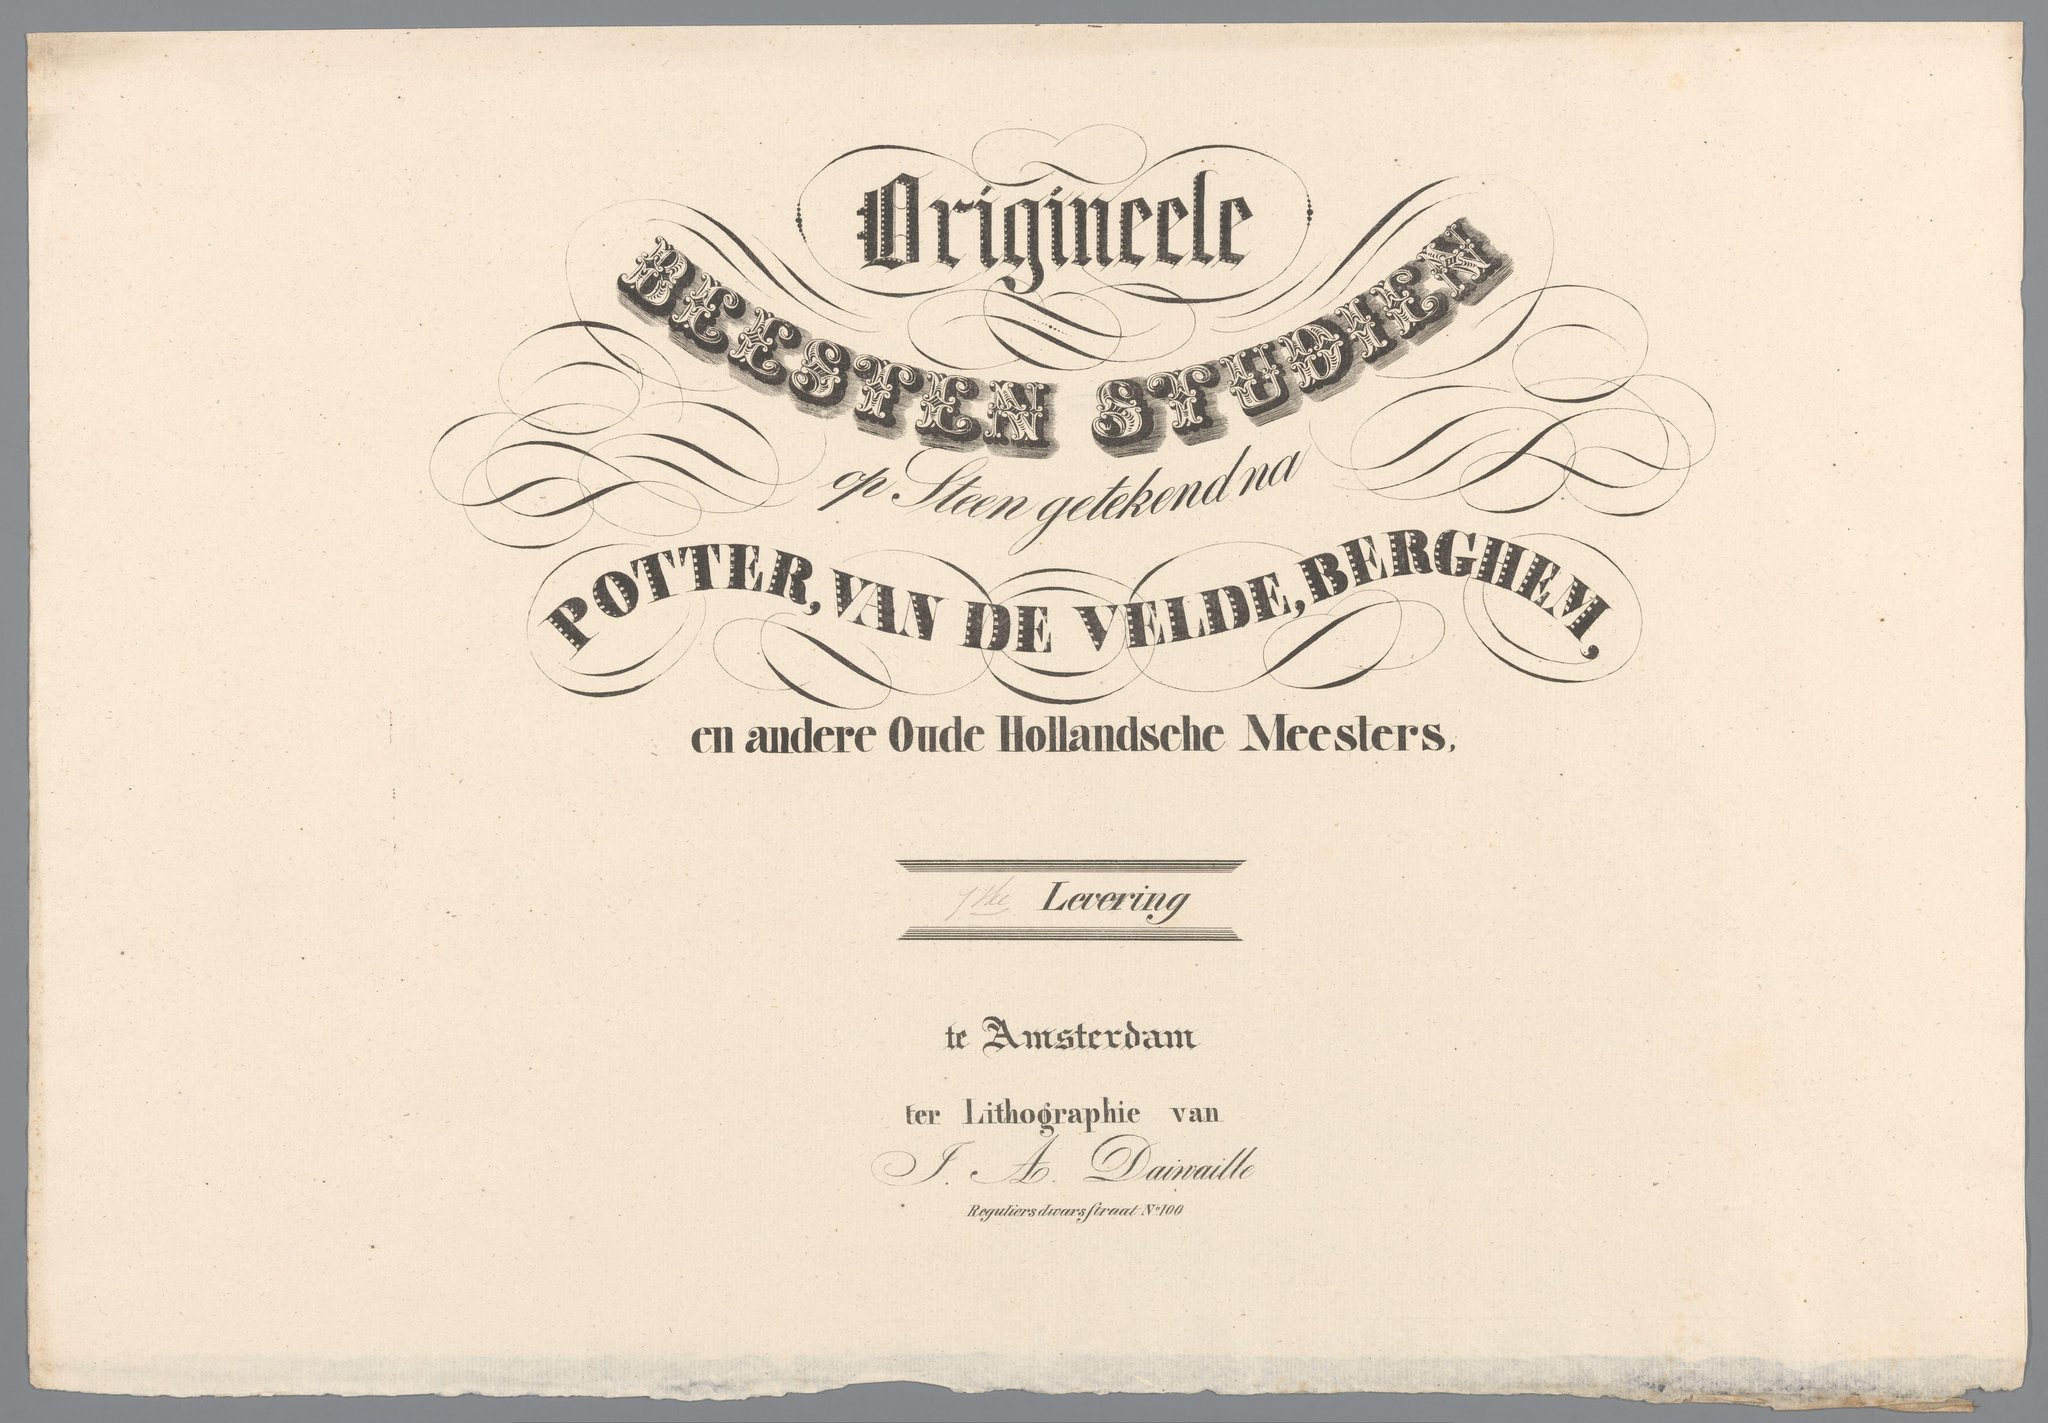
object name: wrapper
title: Origineele Beesten Studien op Steen getekend na Potter, Van de Velde, Berghem, en andere Oude Hollandsche Meesters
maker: jean augustin daiwaille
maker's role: draughtsman, print maker, printer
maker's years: 1786-1850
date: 1820-1833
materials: paper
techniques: lithograph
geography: amsterdam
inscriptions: inscription:, collector's mark: ‘1ste’ Lugt 2228